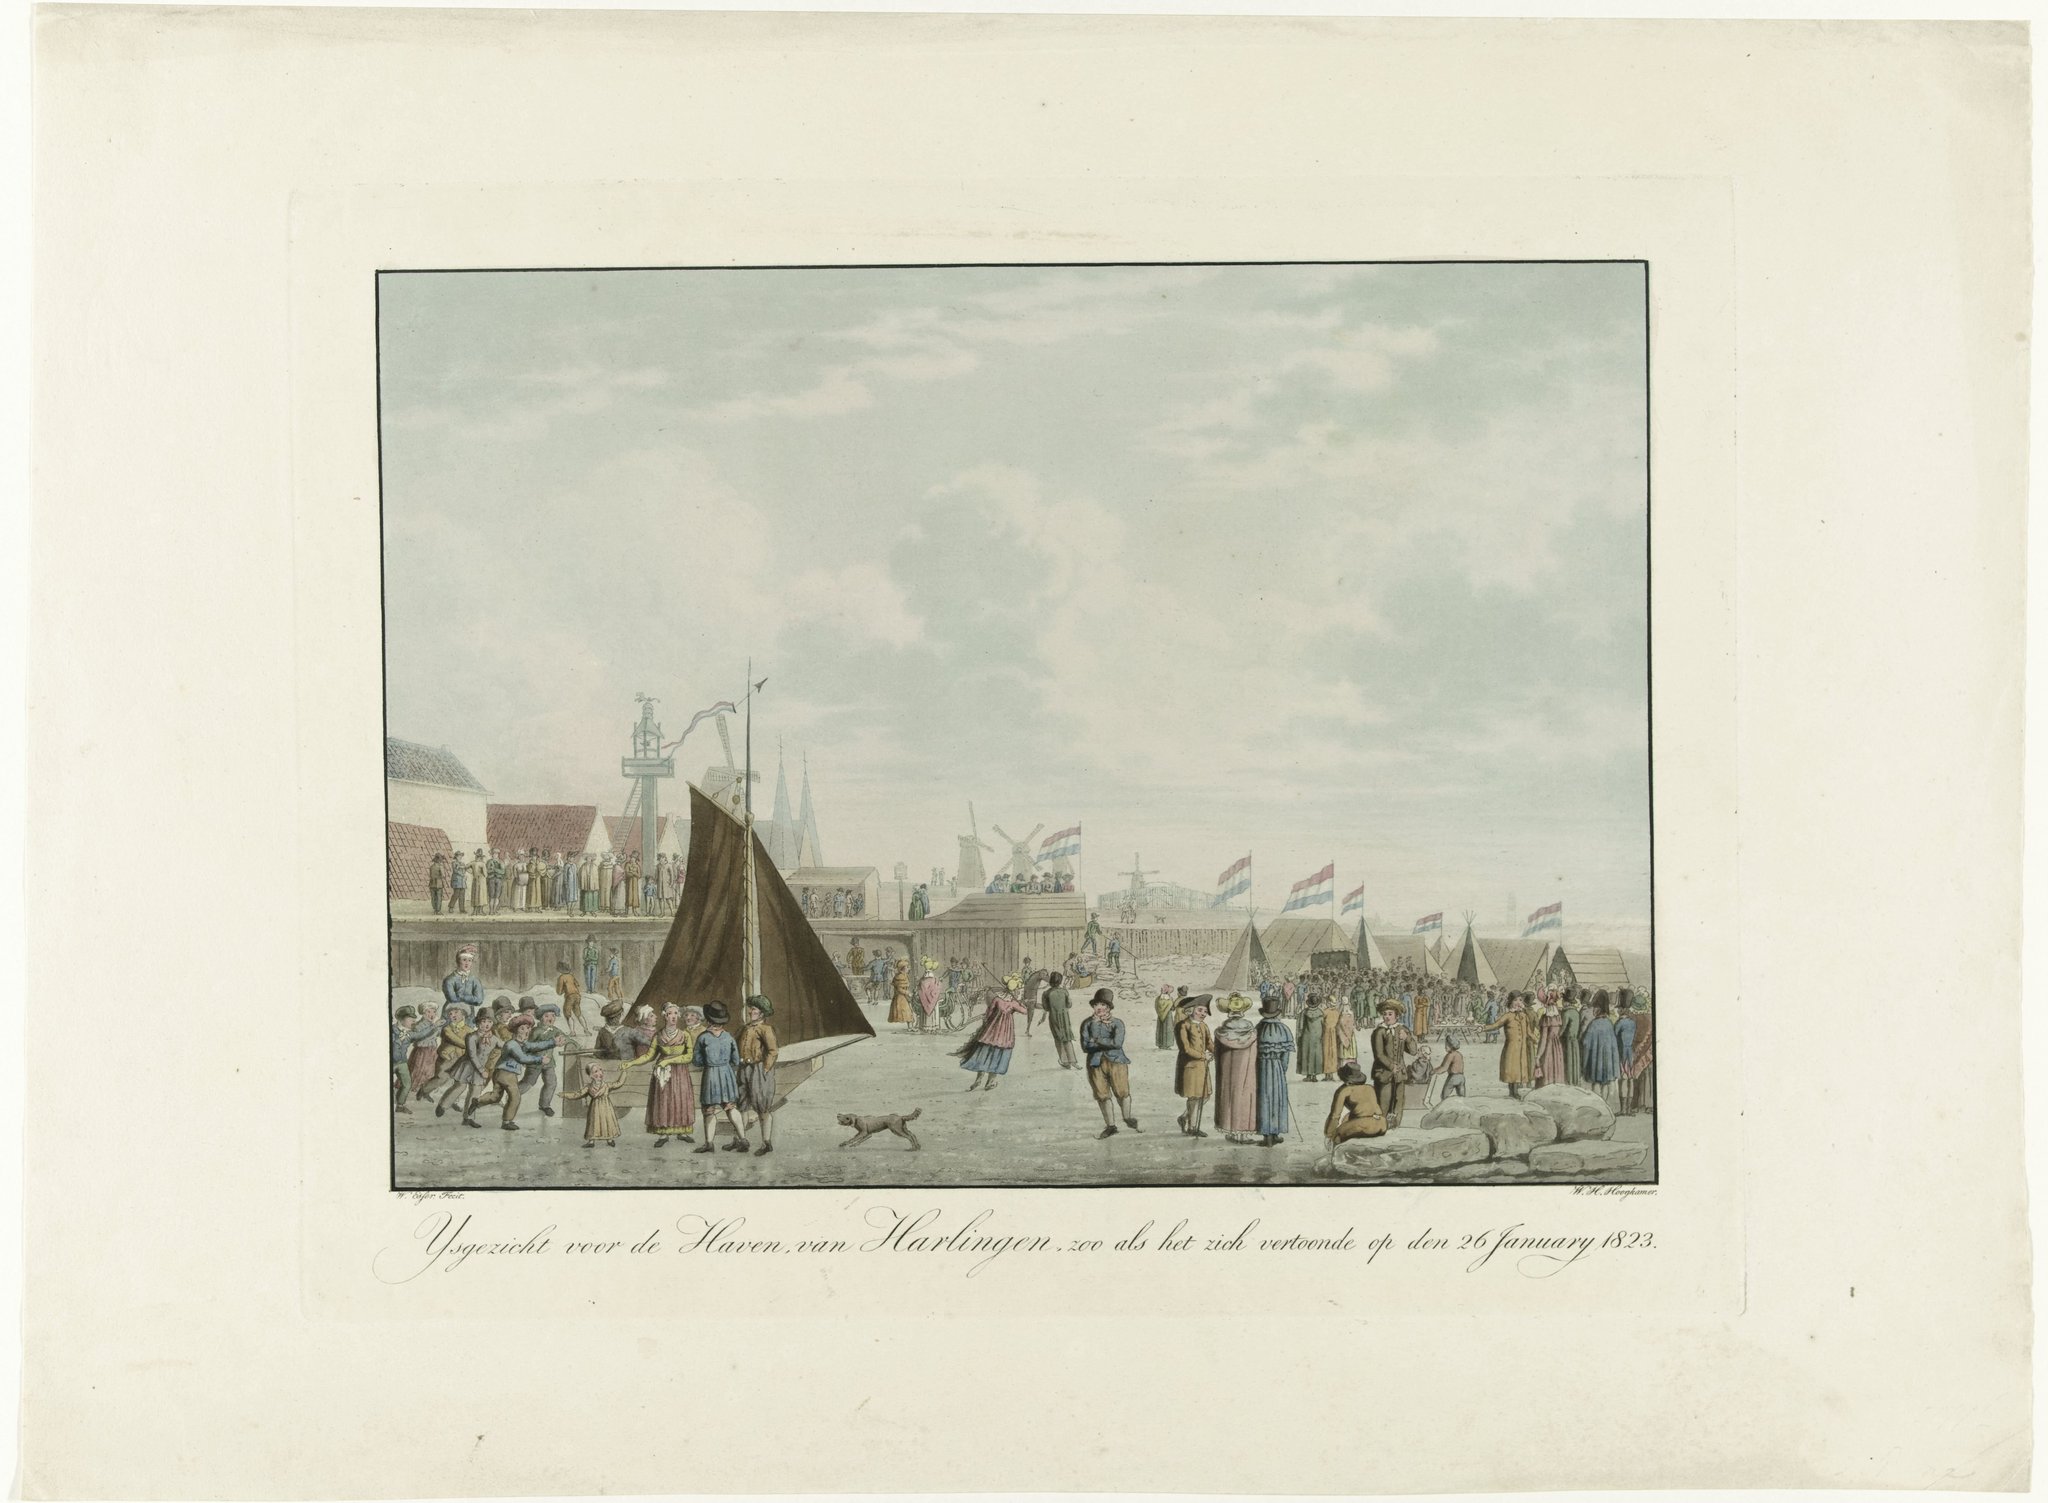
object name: print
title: IJsgezicht voor de Haven, van Harlingen, zo als het zich vertoonde op den 26 January 1823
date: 1823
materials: paper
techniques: aquatint, etching, hand coloring, lithography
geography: netherlands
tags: ice-sailing (winter sports), ice ~ freezing weather, skates (winter sports), sledge, sleigh (winter sports), harlingen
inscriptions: inscription: ‘WEsser’, collector's mark: Lugt 2228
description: IJspret op de dichtgevroren haven van Harlingen, 26 januari 1823. Links een ijsschuit achtervolgd door een groep kinderen, rechts tenten op het ijs waar eten en drinken wordt verkocht (koek en zopie), in het midden een slee en enkele schaatsers. Zie ook de pendant.